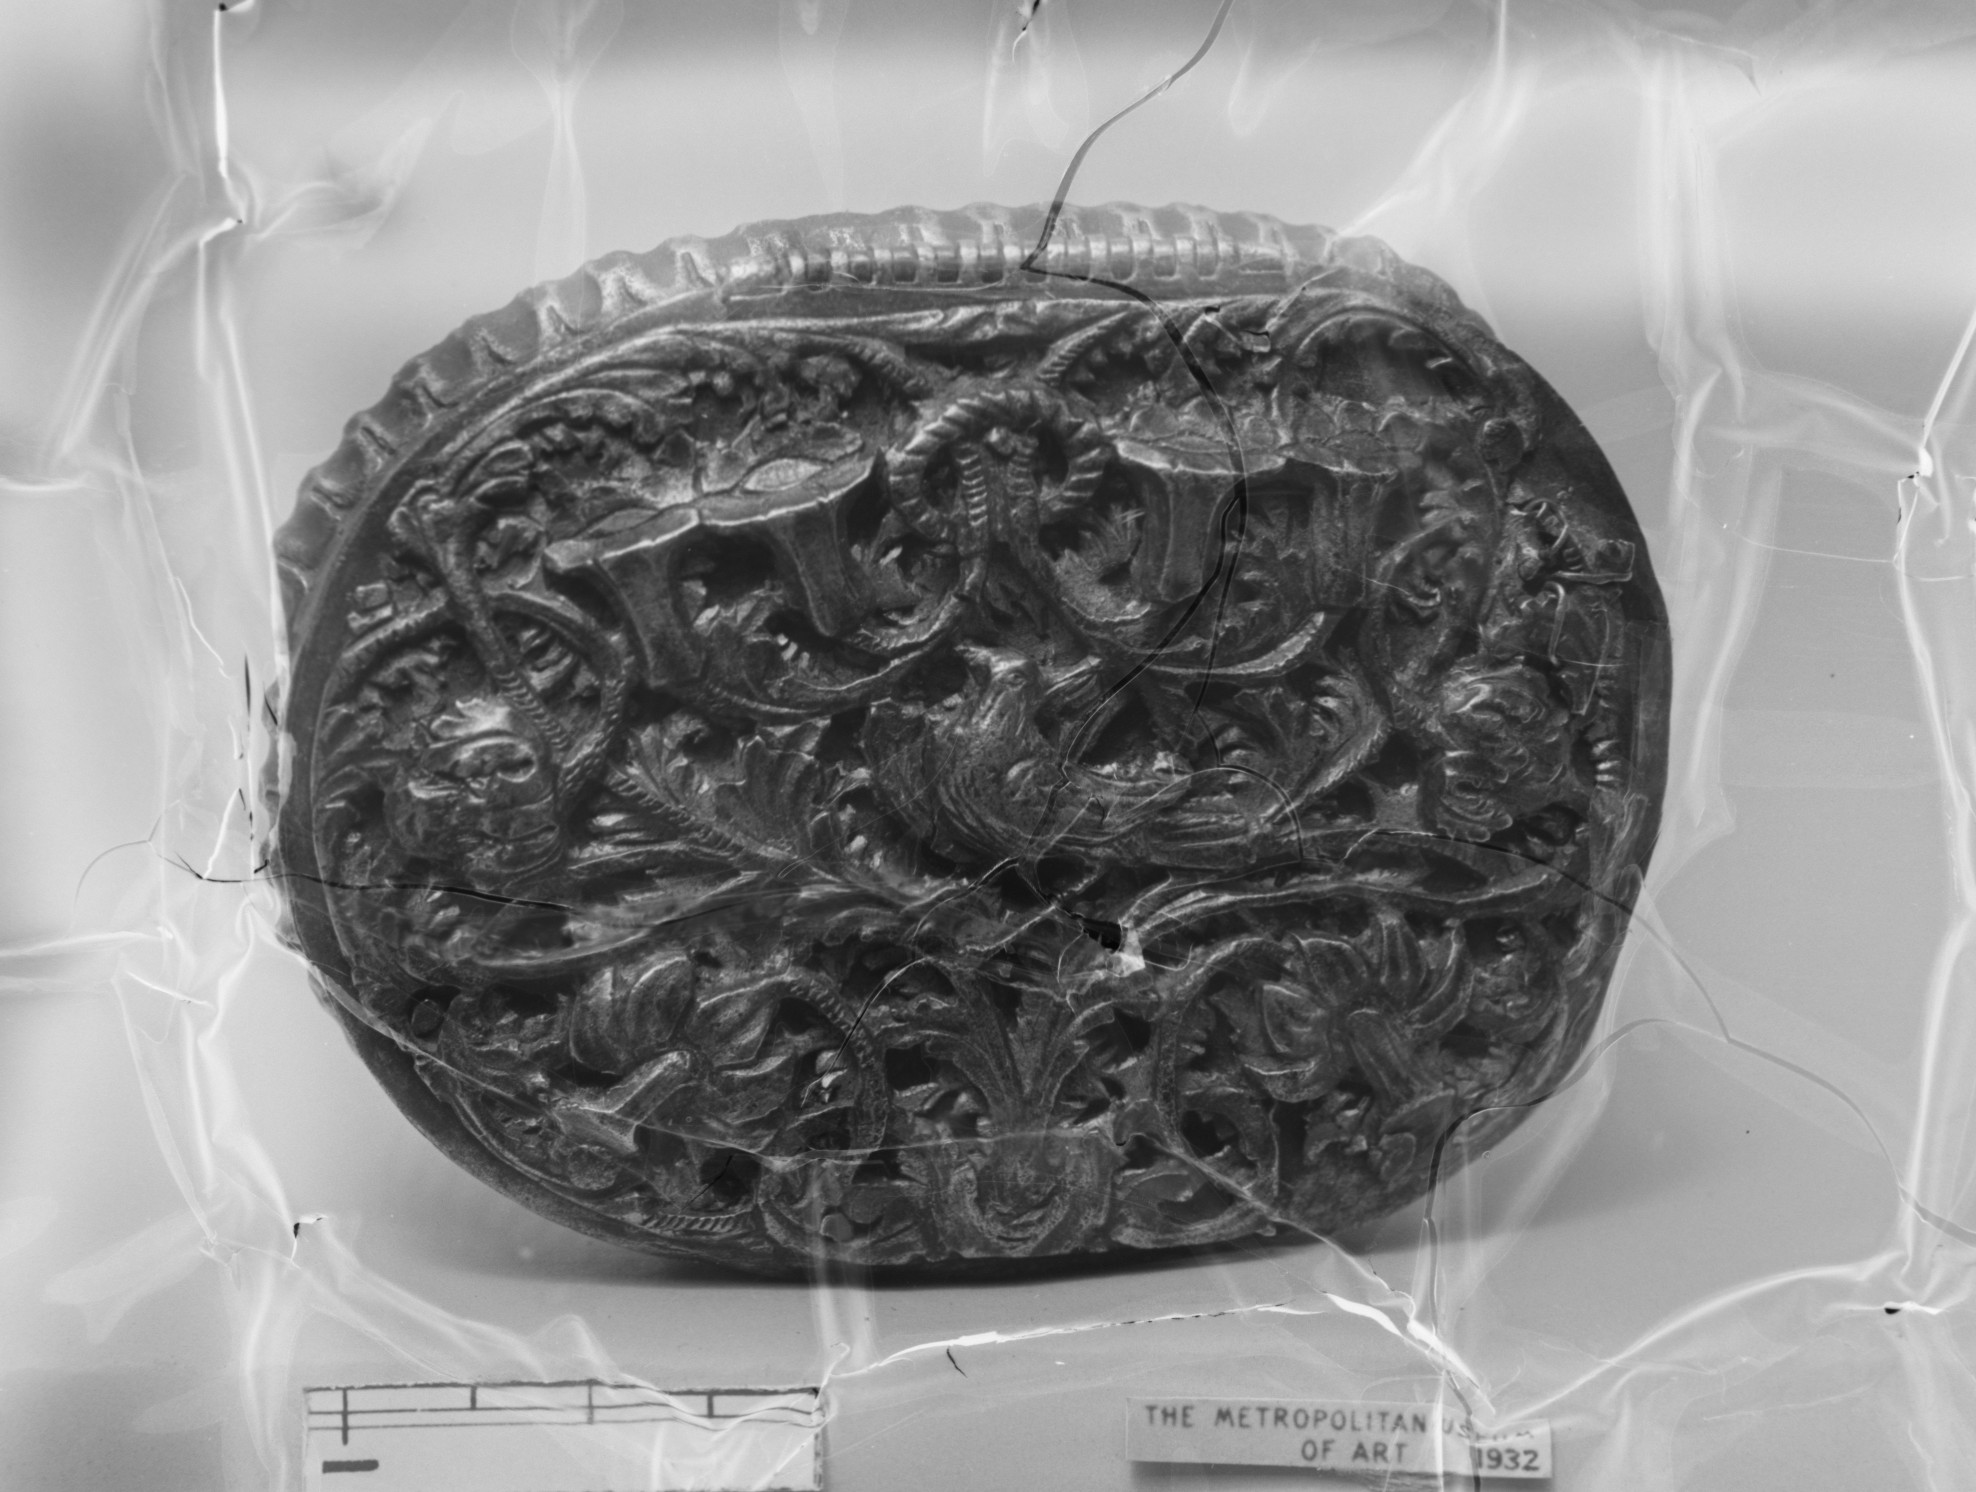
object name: box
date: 1601-1700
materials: iron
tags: flowers